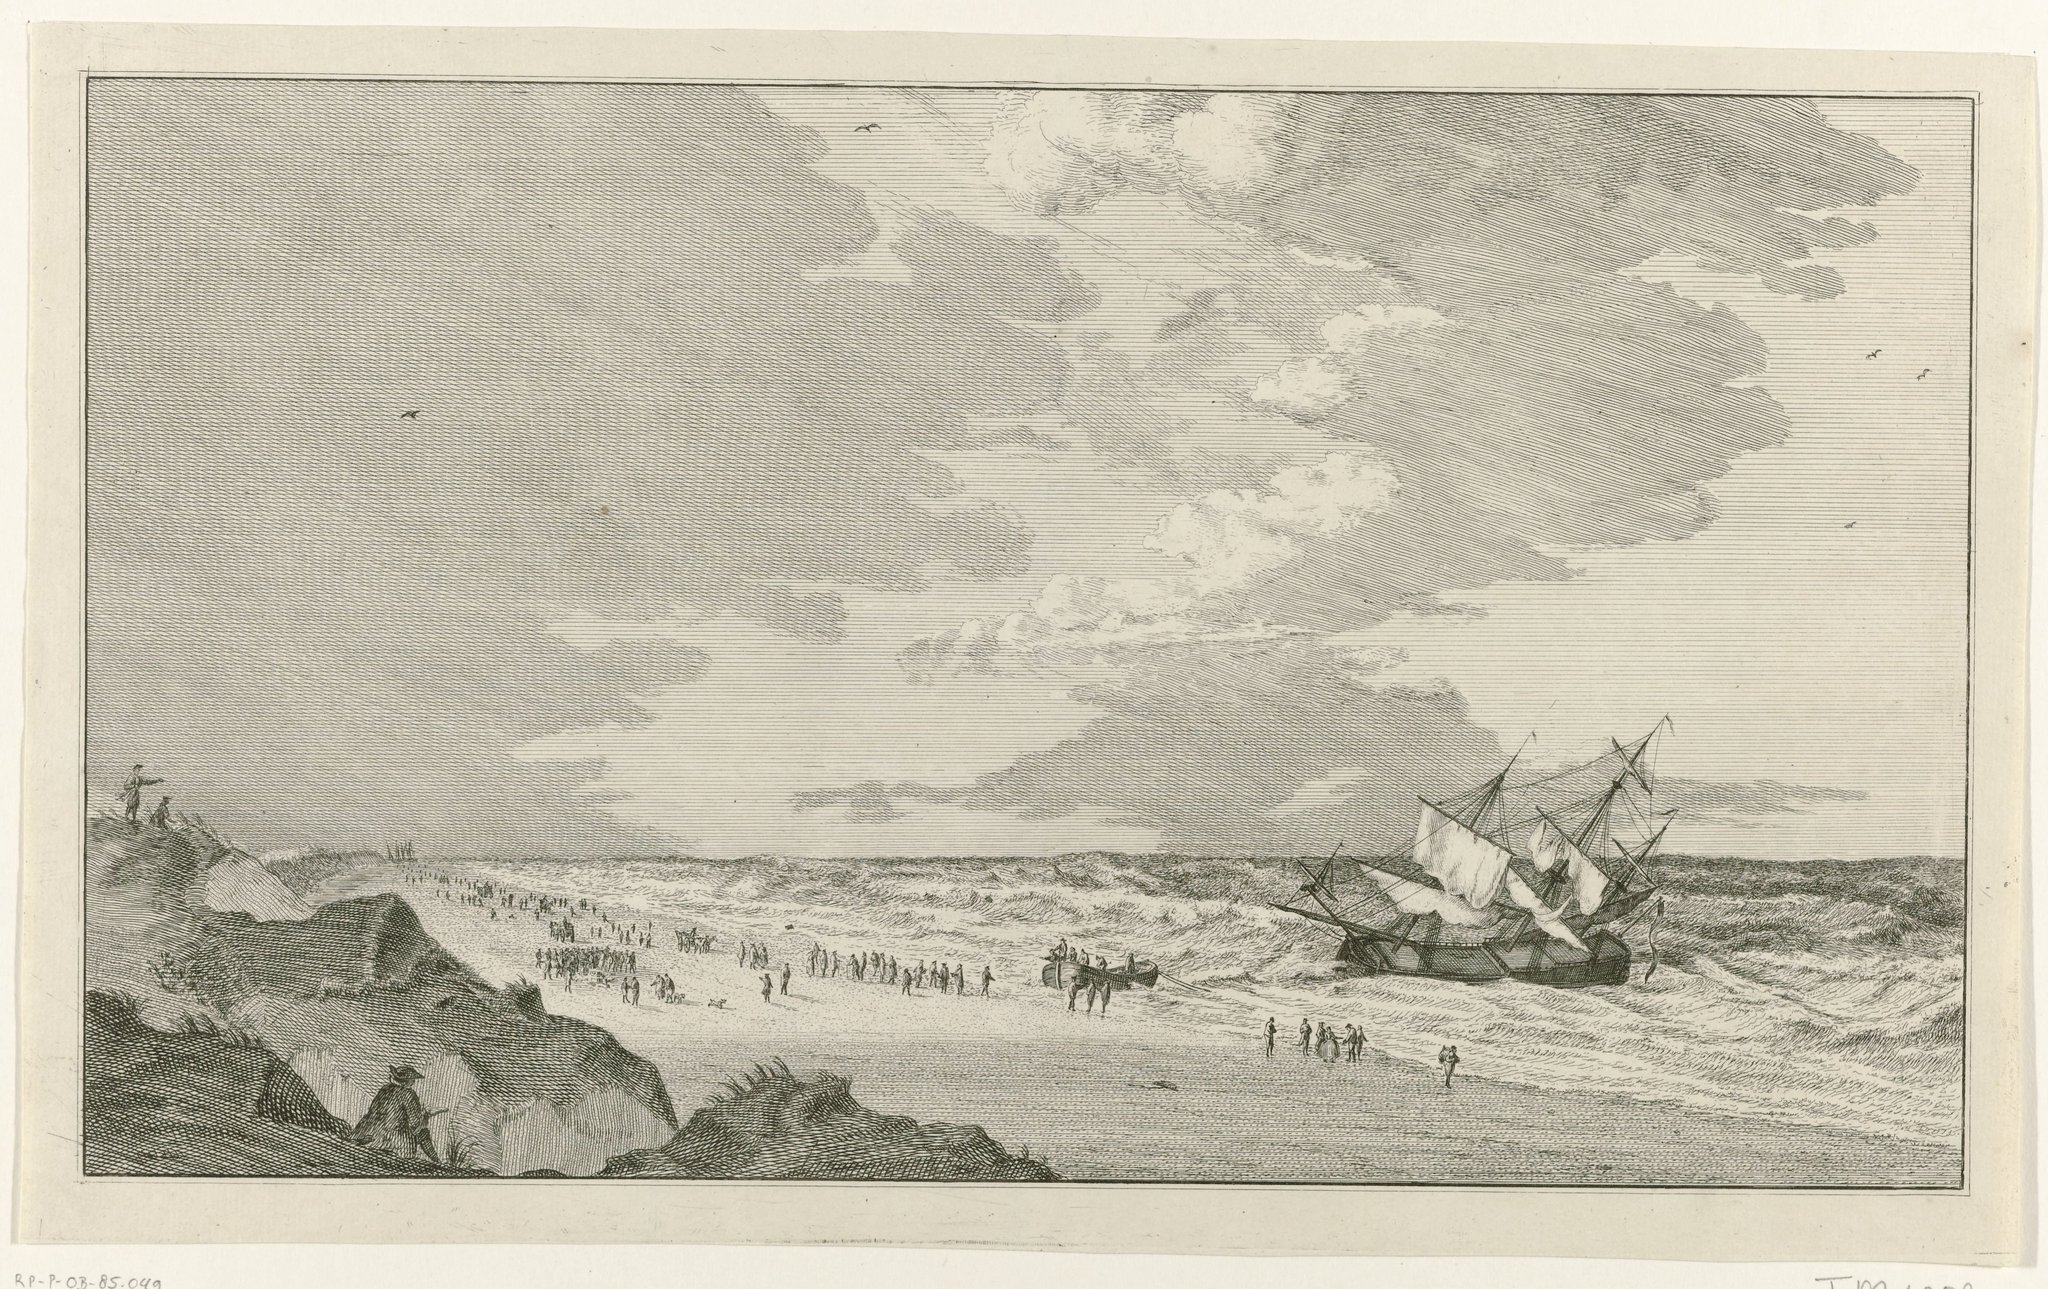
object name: print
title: De bemanning verlaat een schip gestrand bij Egmond aan Zee, 1780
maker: Anonymous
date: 1742-1780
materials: paper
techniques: engraving, etching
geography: northern netherlands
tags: shipwreck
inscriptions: collector's mark: Lugt 2228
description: De bemanning verlaat een schip gestrand bij Egmond aan Zee, 14 november 1780. Gezicht vanaf de duinen, op de voorgrond zit een tekenaar. Mogelijk een voorstelling van een stranding in 1742.